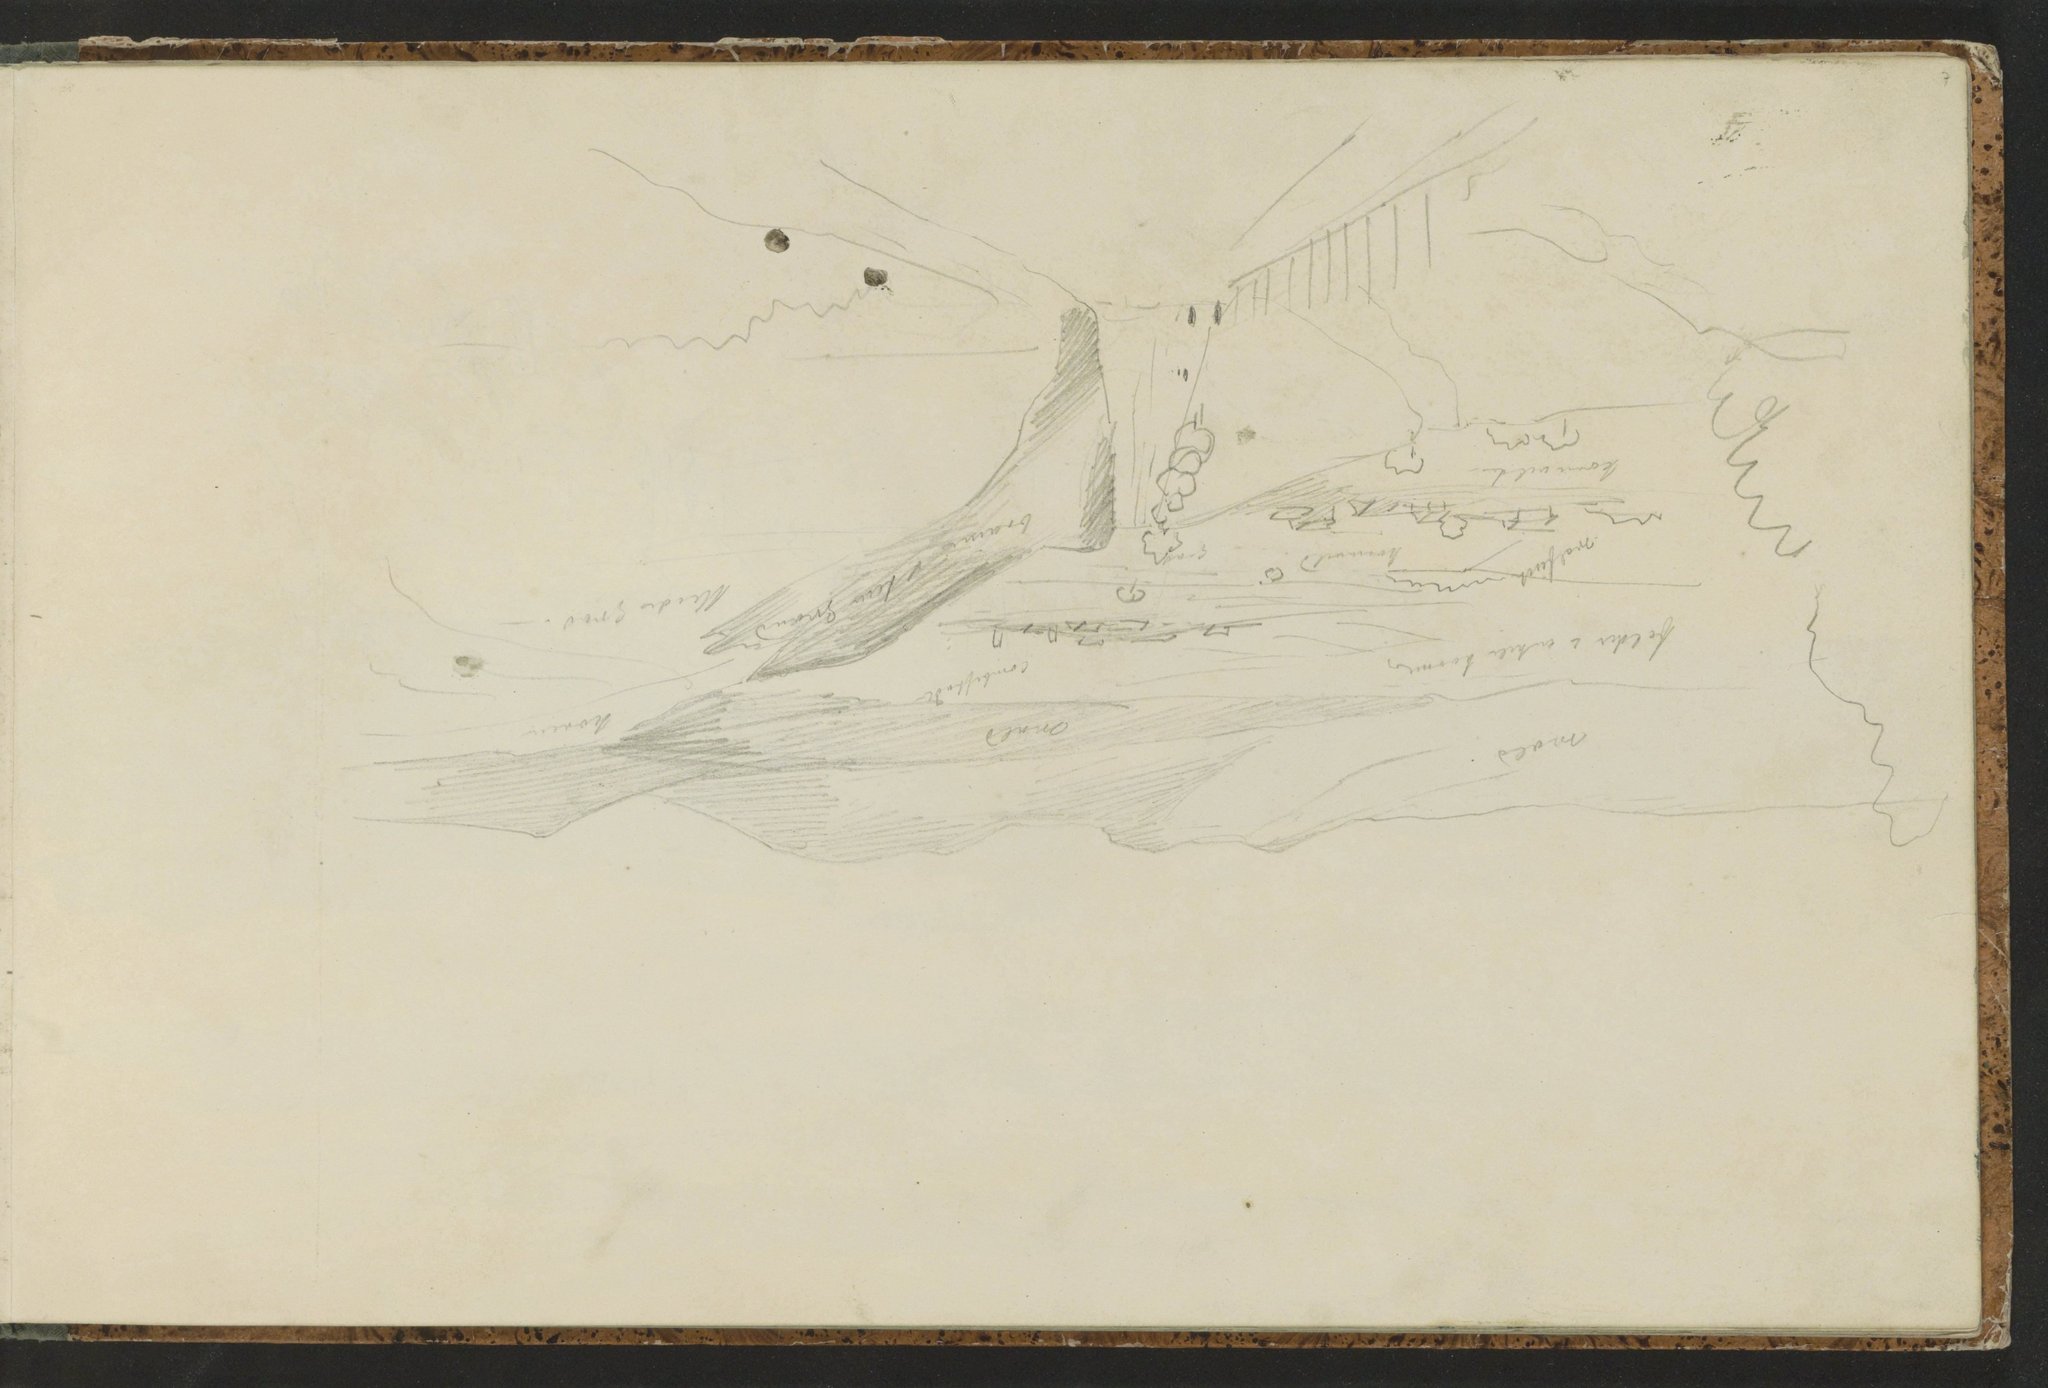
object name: sketchbook leaf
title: Weg in een berglandschap, vermoedelijk het Thüringer Wald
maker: johannes tavenraat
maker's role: draughtsman, painter, print maker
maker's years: 1809-1881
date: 1840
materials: paper, pencil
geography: schwarzburg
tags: road, path, mountains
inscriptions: kleurnotitie, handgeschreven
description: Blad 7 recto uit een schetsboek met 33 bladen.